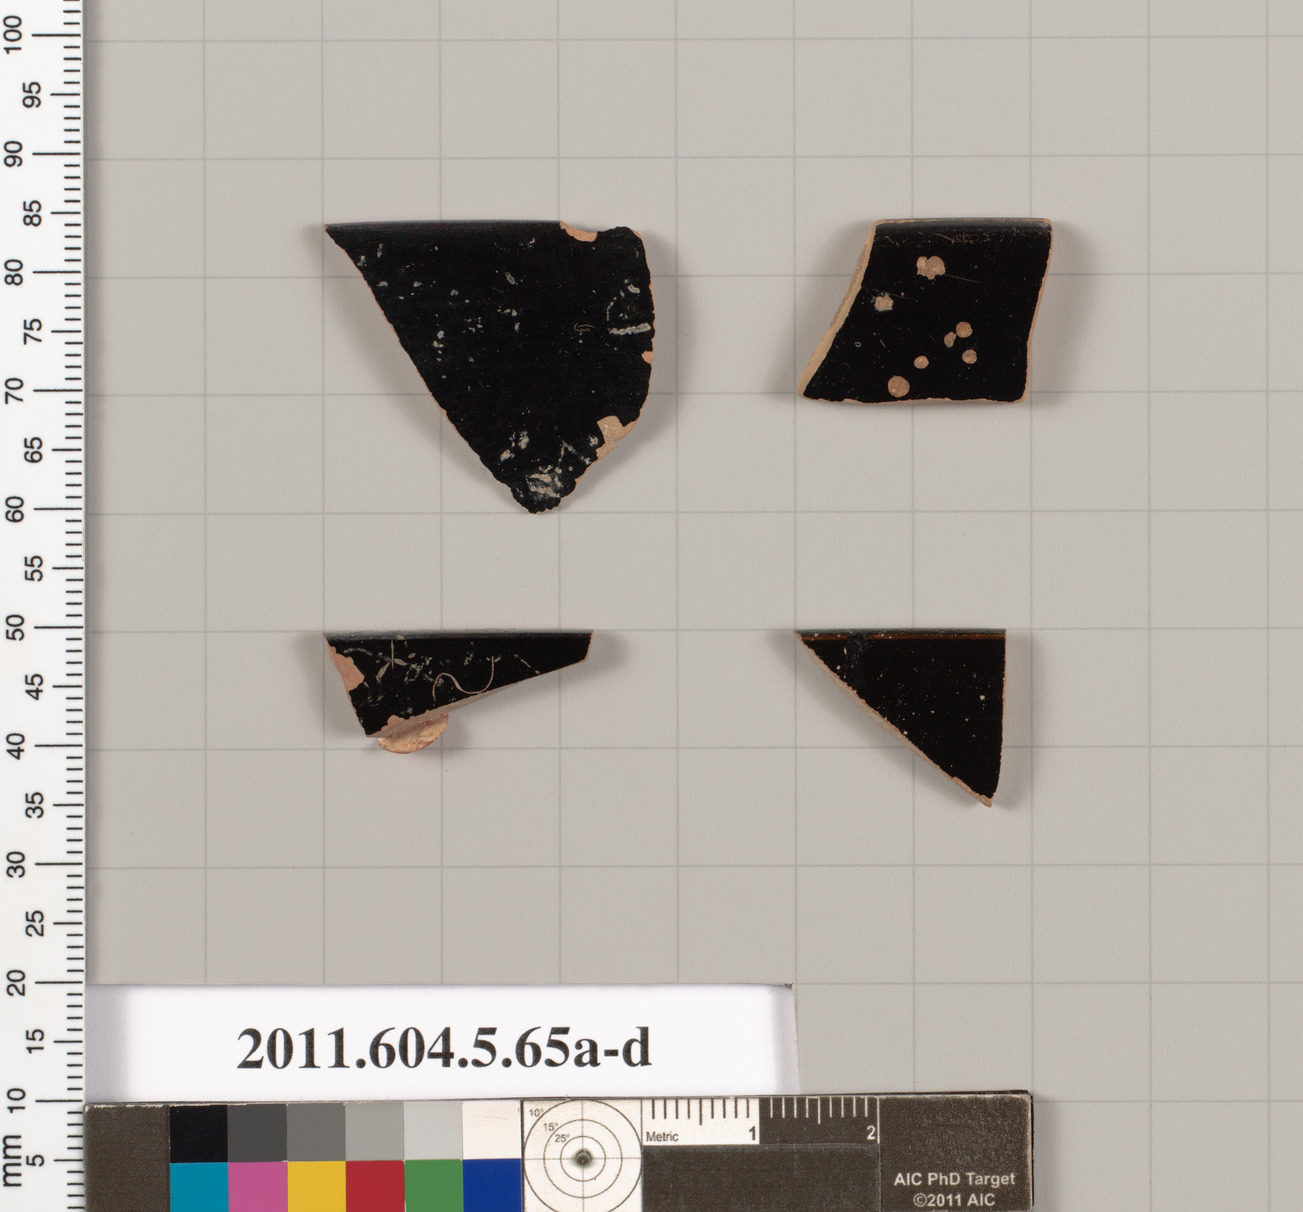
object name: kylix fragment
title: Terracotta rim fragments of kylikes (drinking cups)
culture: greek, attic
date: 500-401 BCE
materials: terracotta